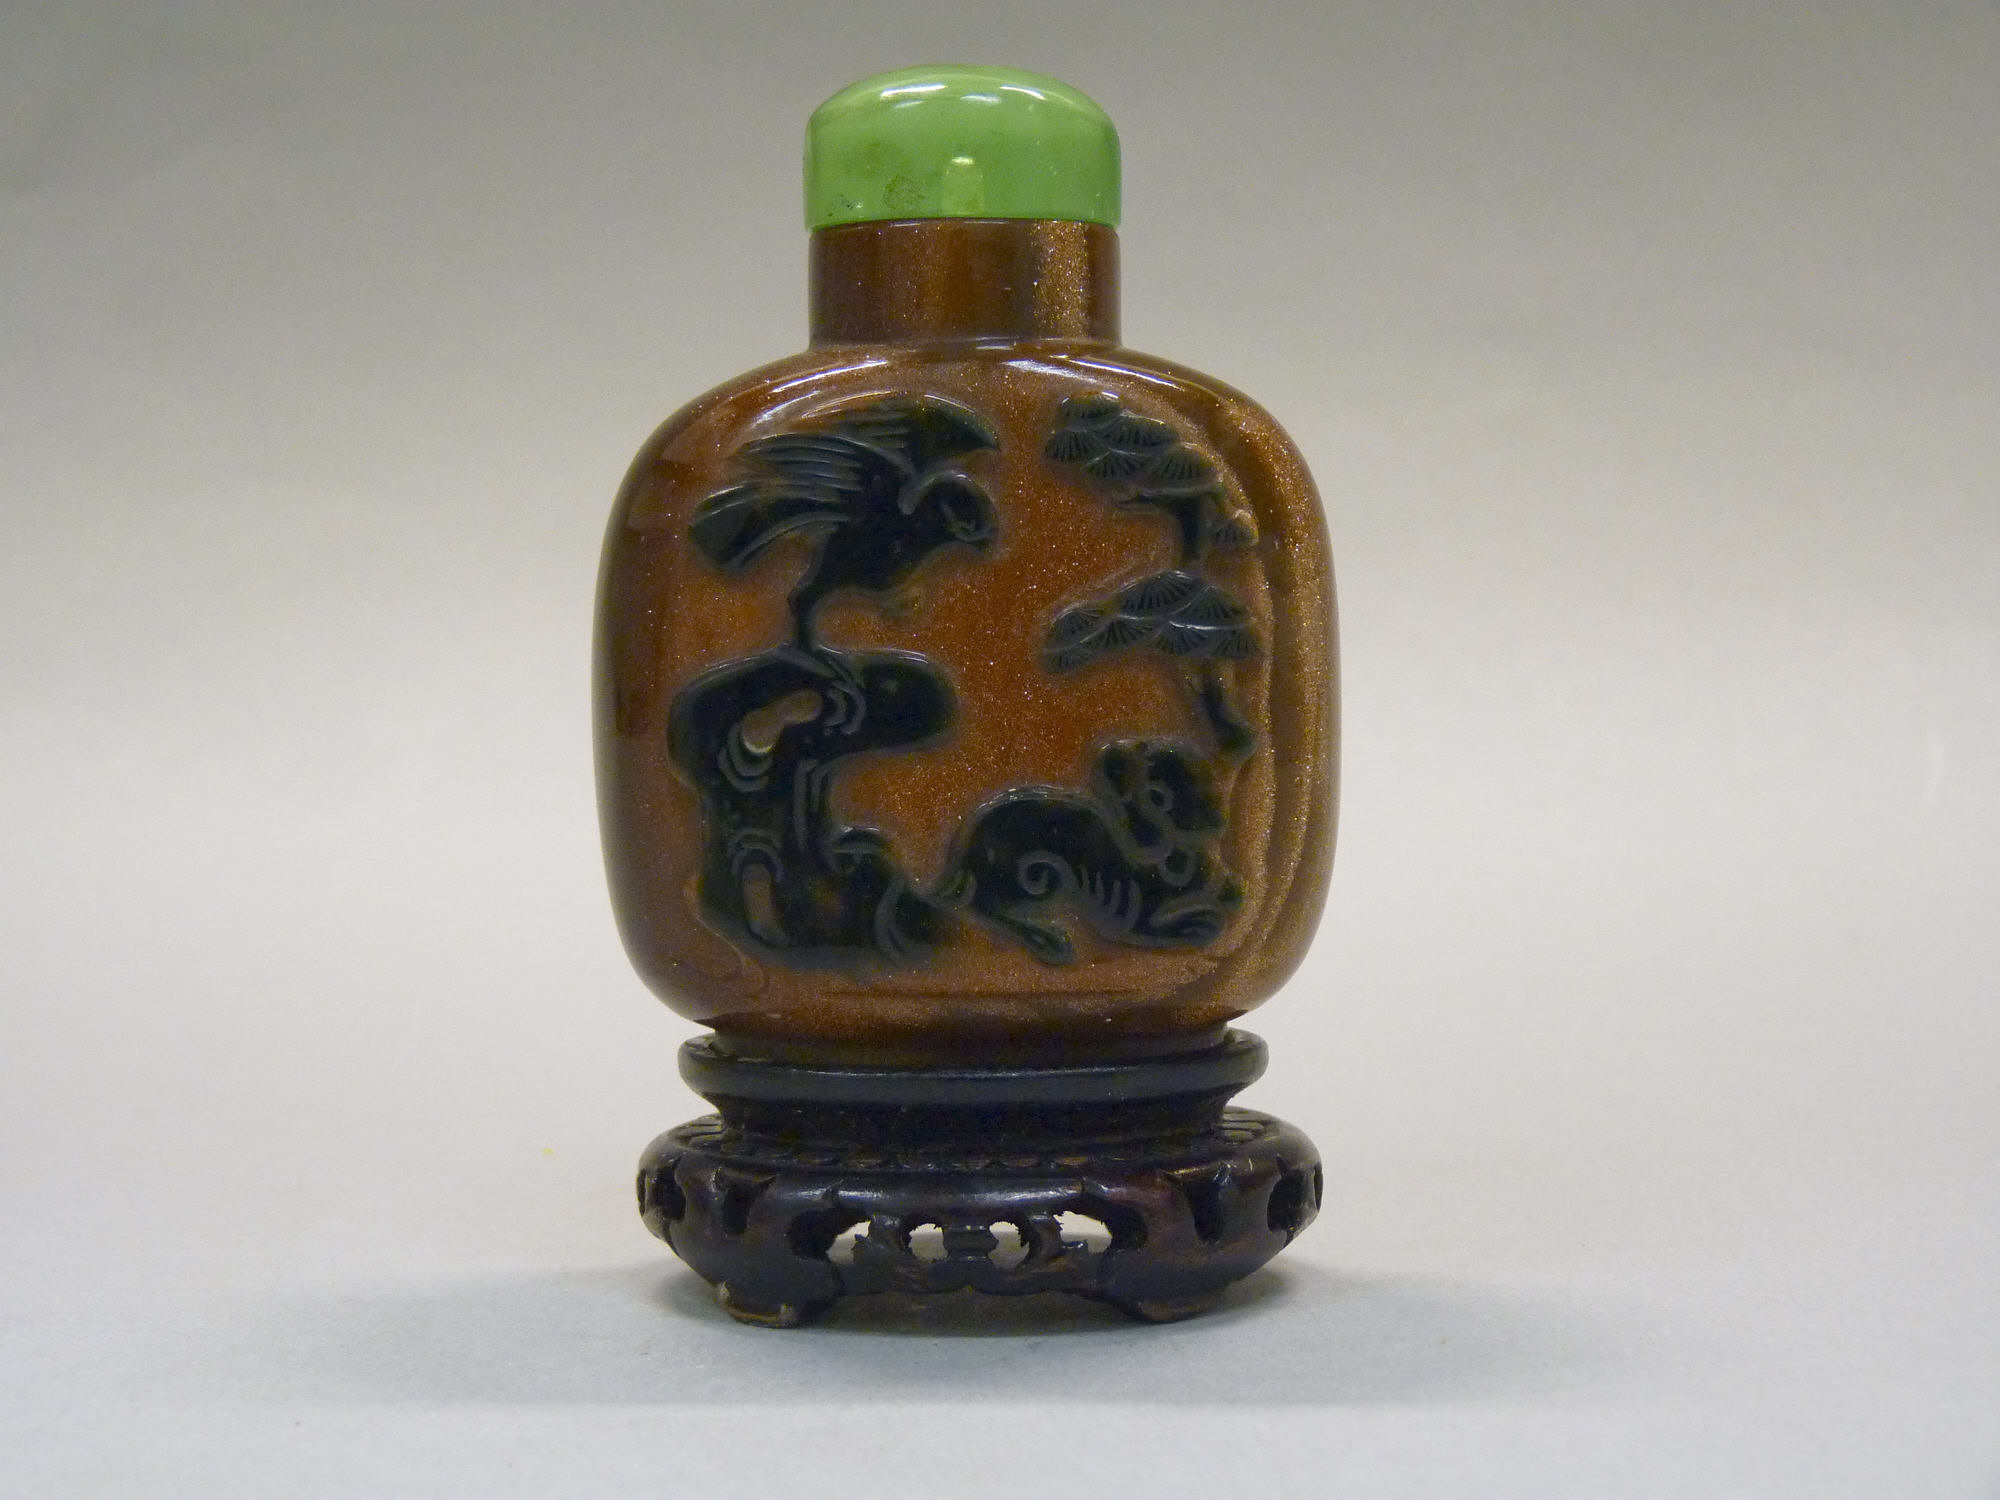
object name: snuff bottle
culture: chinese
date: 1801-1900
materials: glass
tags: animals,birds